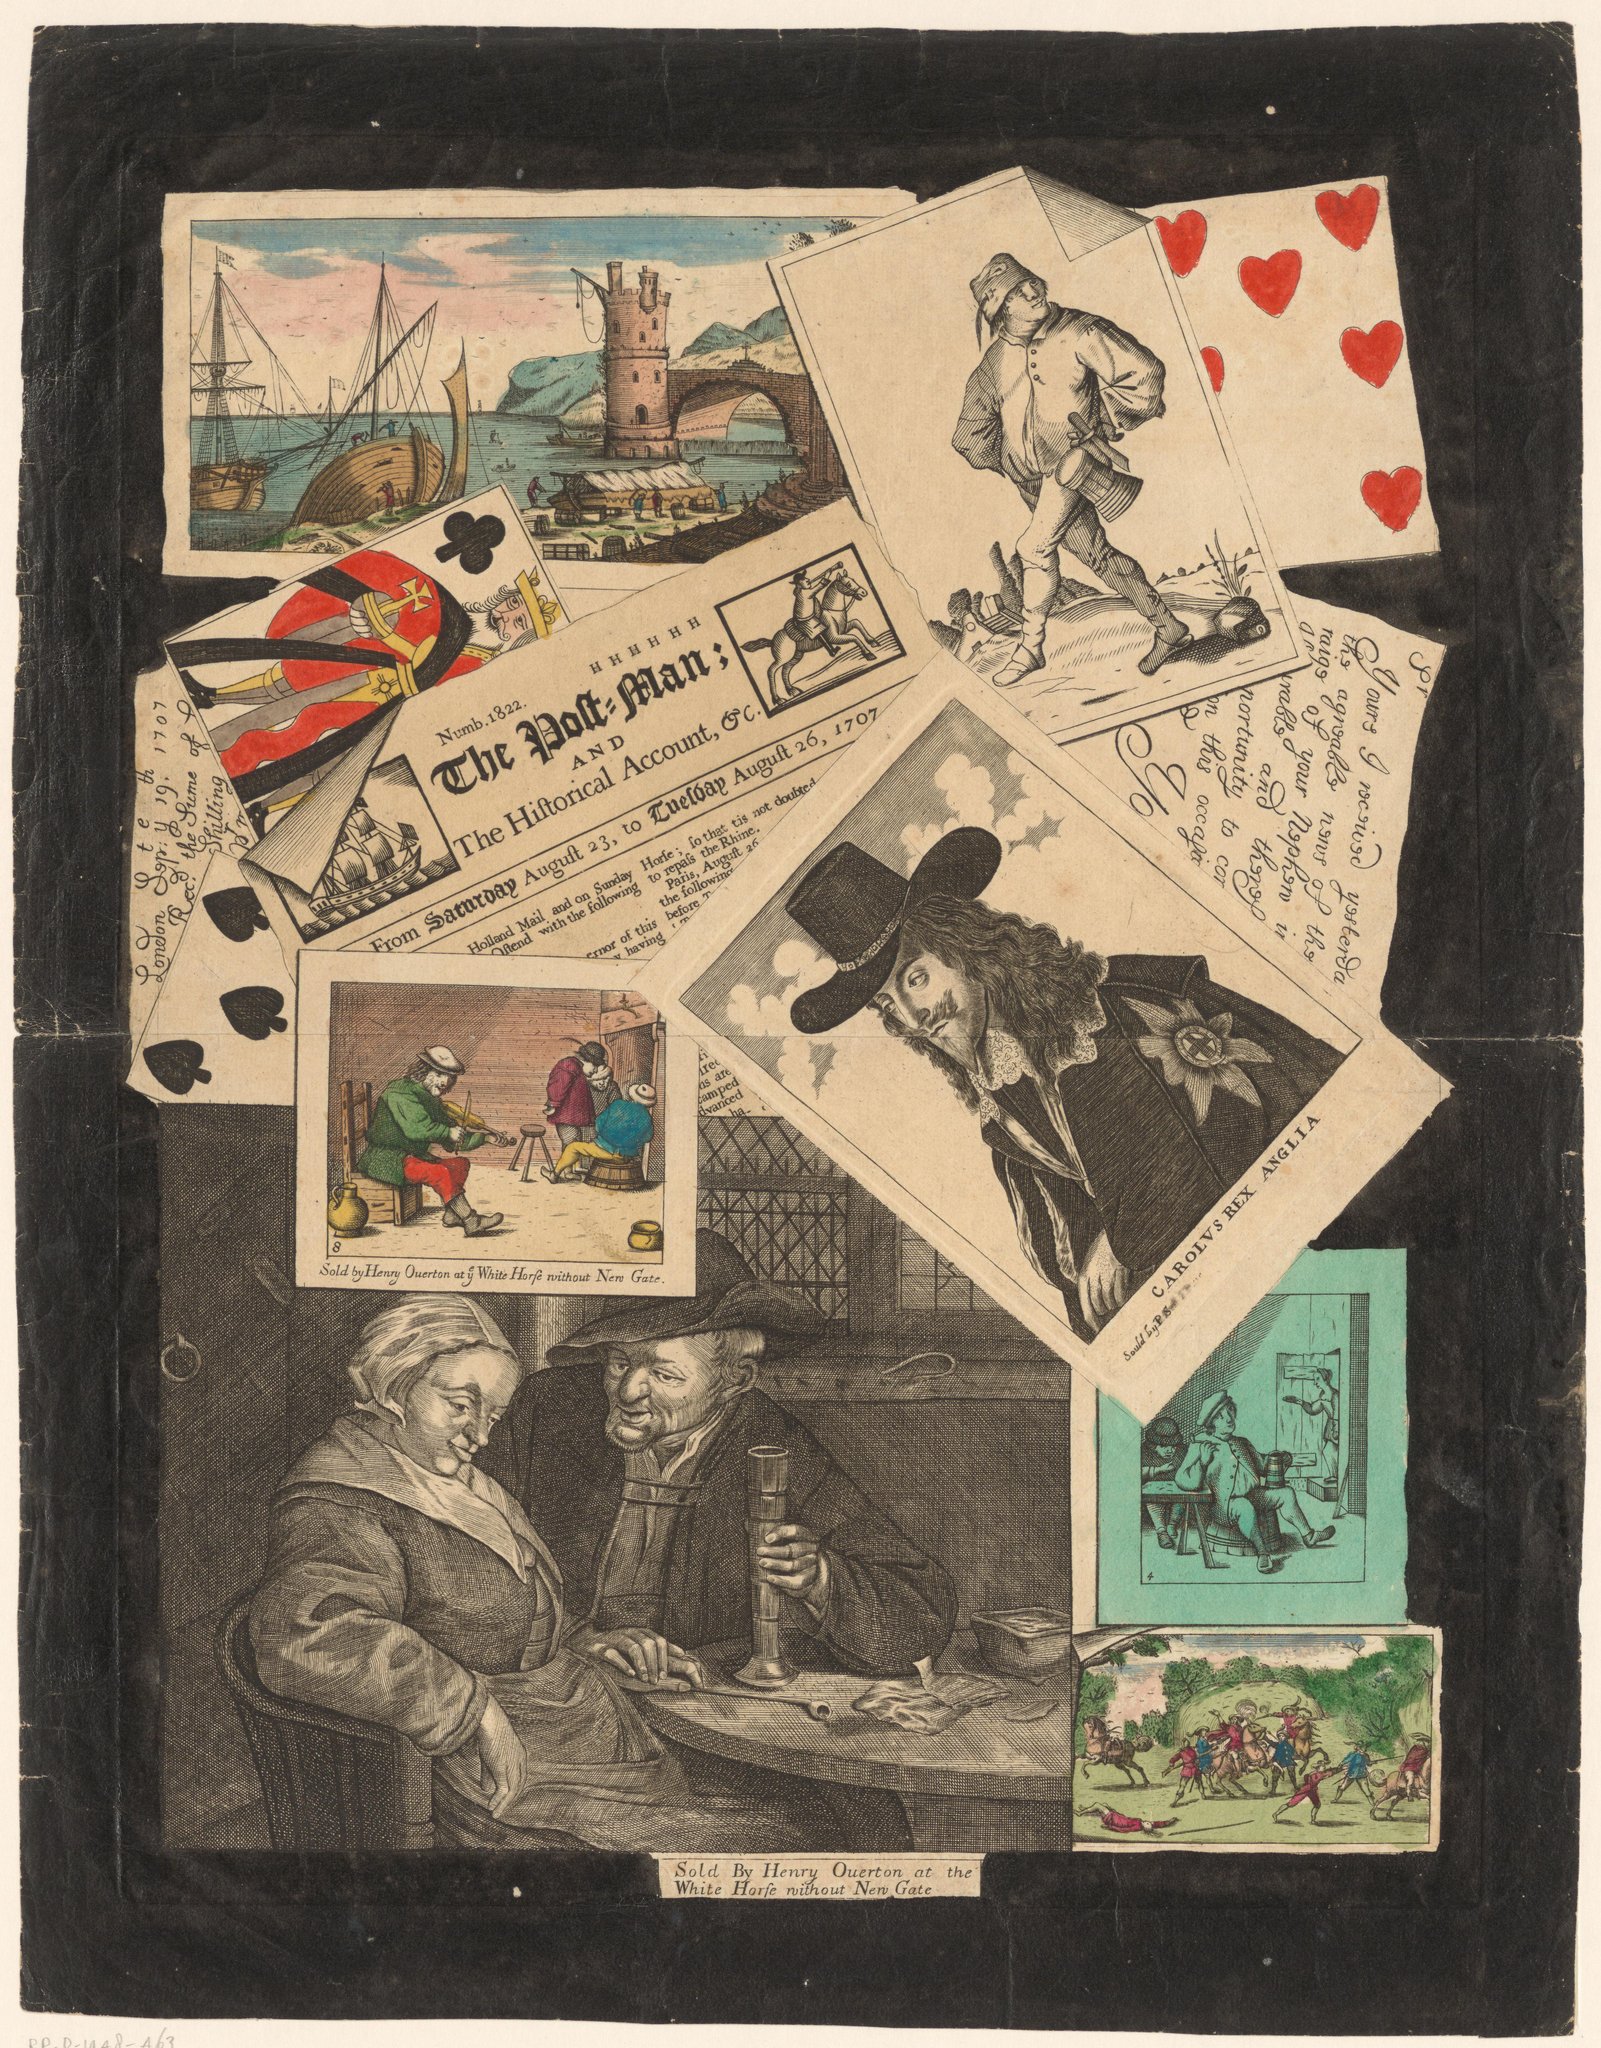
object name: print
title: Trompe l'oueil met drie speelkaarten, een krantenknipsel, een brief en zes prenten met genretaferelen, landschappen en een portret van een koning van Engeland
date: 1707-1751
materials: paint, paper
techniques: engraving, etching, hand coloring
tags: print, e.g.: engraving, etching, lithograph, playing-cards, newspaper, news-sheet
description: Tekst in het Engels in de voorstelling, waaronder de titel van 'The Post-Man; and The Historical Account' uit 1707. Verschillende prenten uitgegeven door Henry Overton en genummerd.